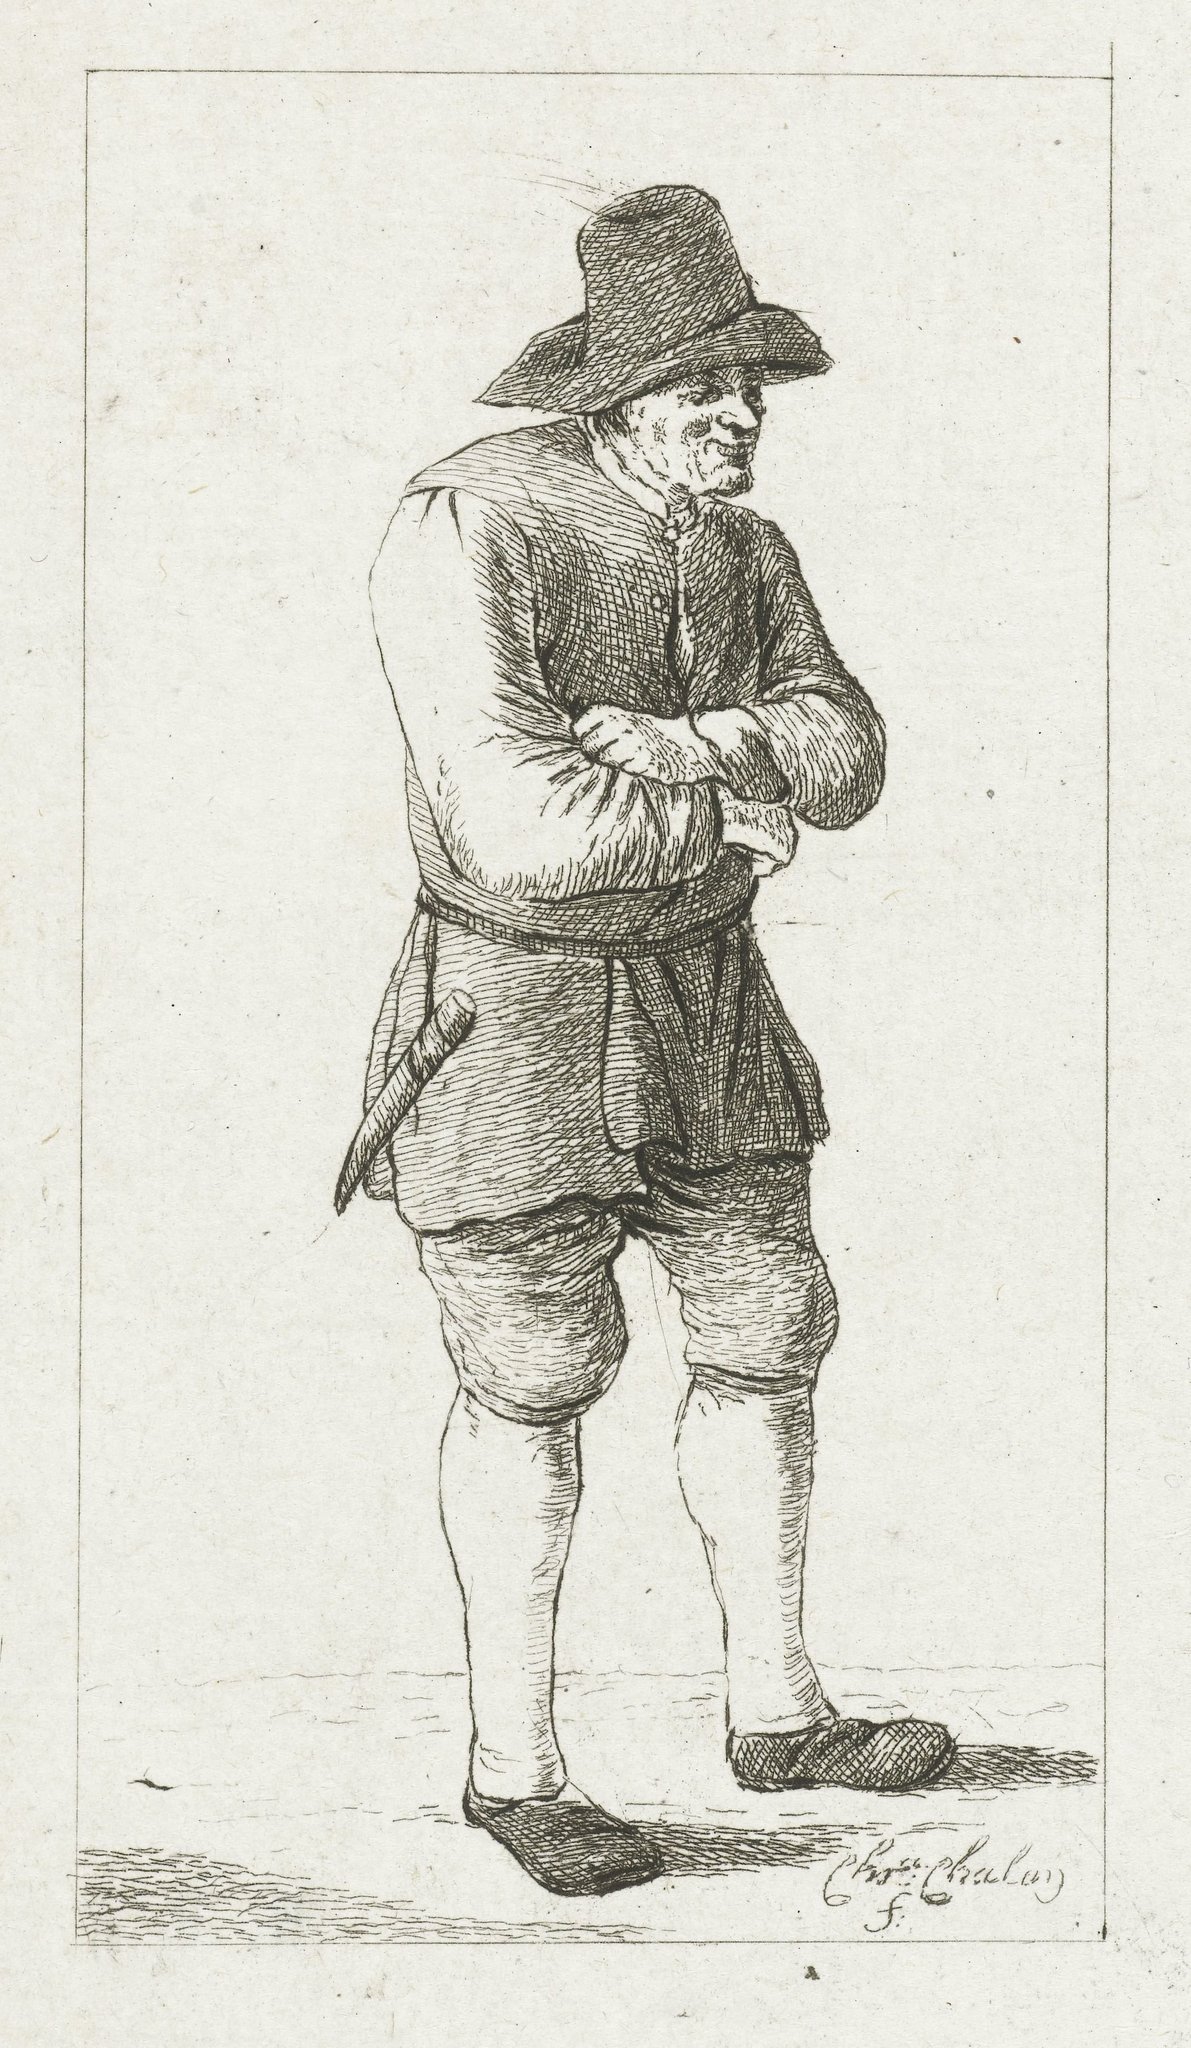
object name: print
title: Staande man met armen over elkaar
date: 1779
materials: paper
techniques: etching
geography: leiden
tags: the (nude) human figure; 'corpo humano' (ripa) (+ old male (human being)), tools, aids, implements ~ crafts and industries: knife, arms crossed over the breast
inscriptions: collector's mark: Lugt 2233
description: Een oude man met een hoed. Hij heeft zijn armen over elkaar en draagt een mes aan zijn zijde.